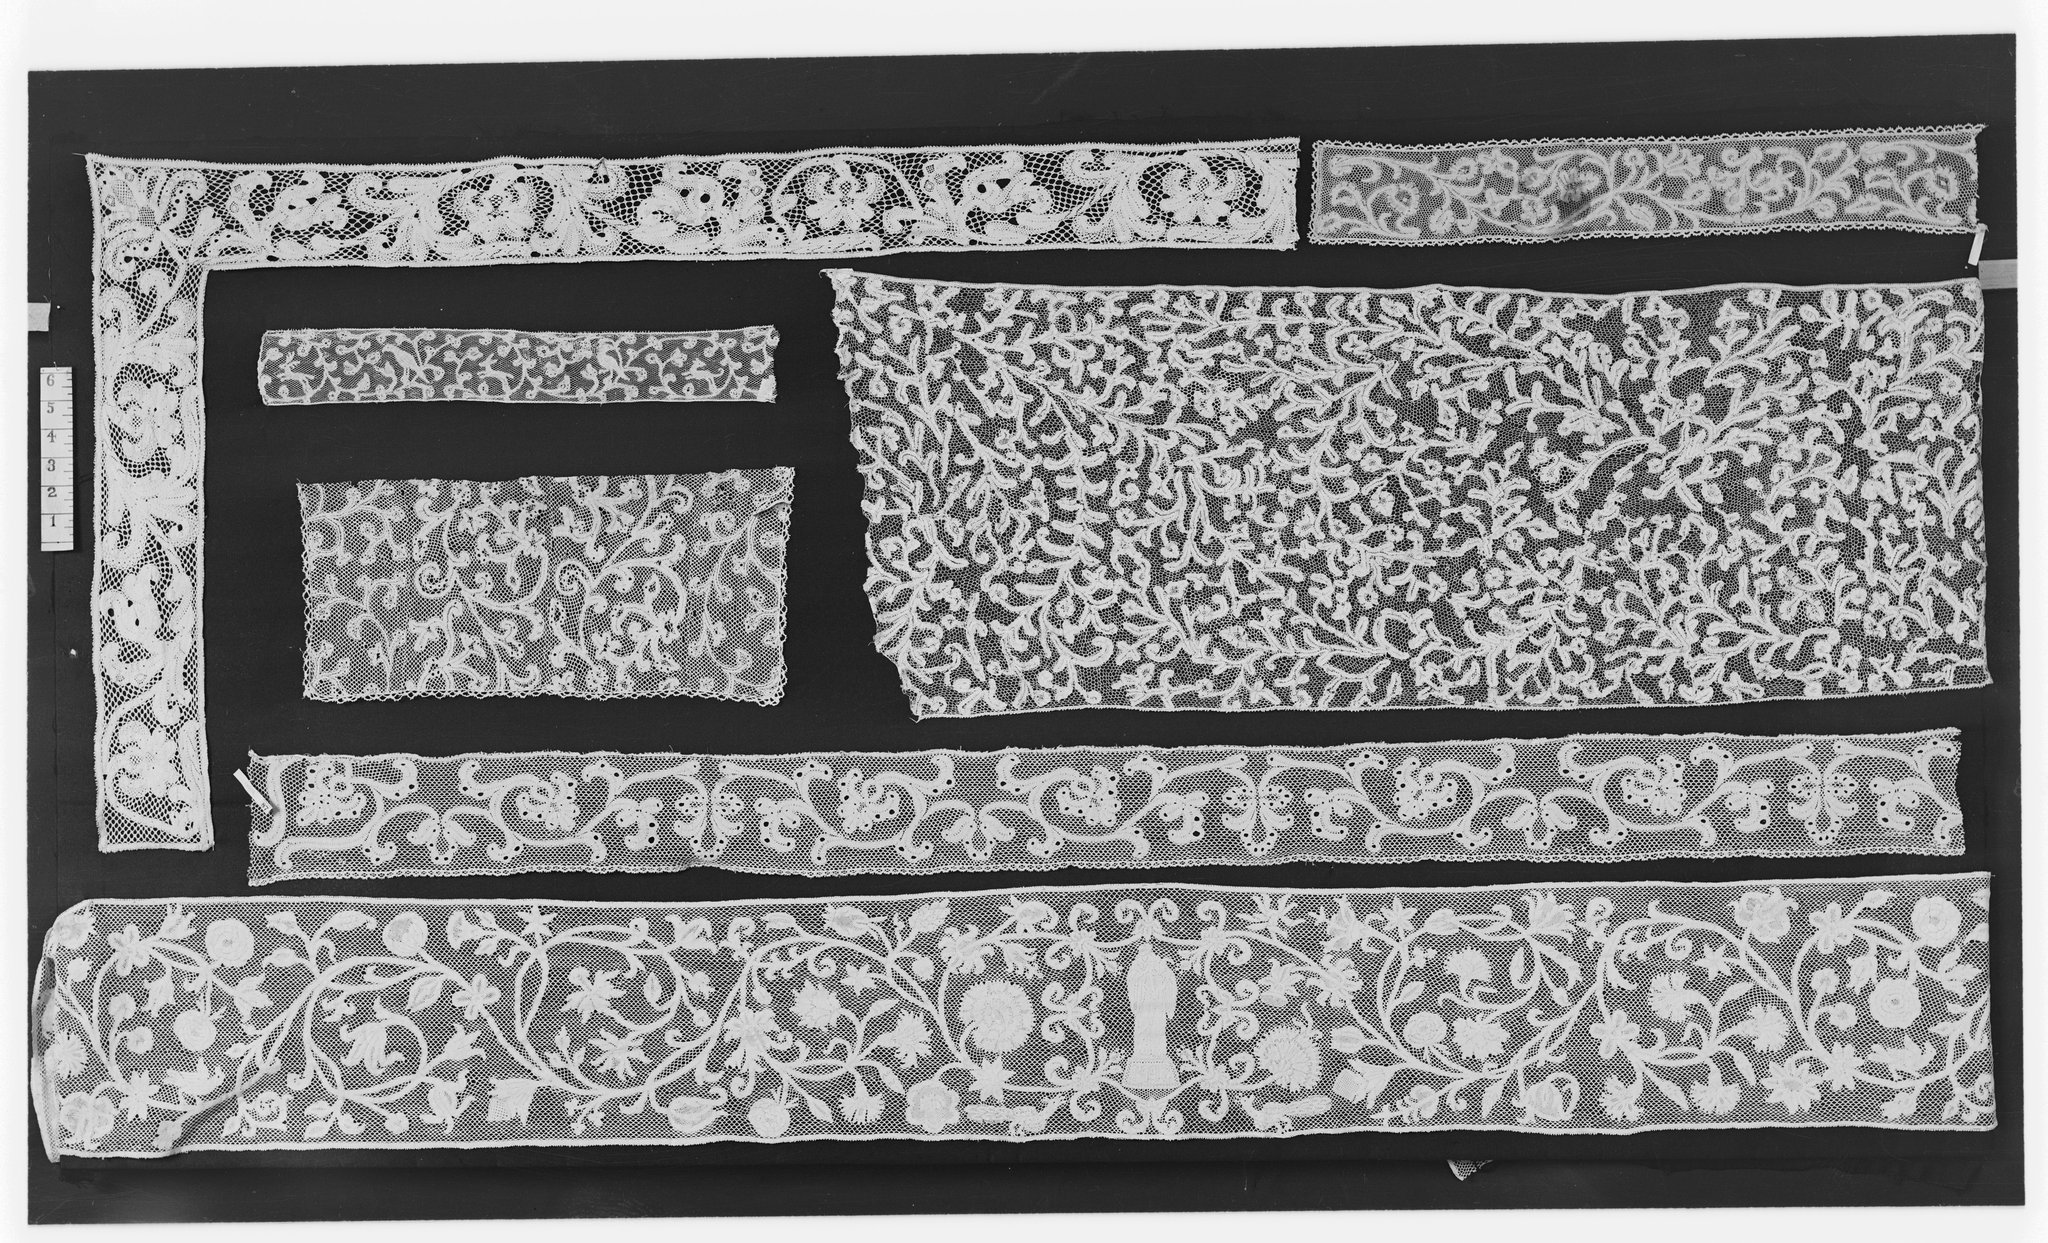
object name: strip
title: Strip with corner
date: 1667-1700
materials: lace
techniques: lace